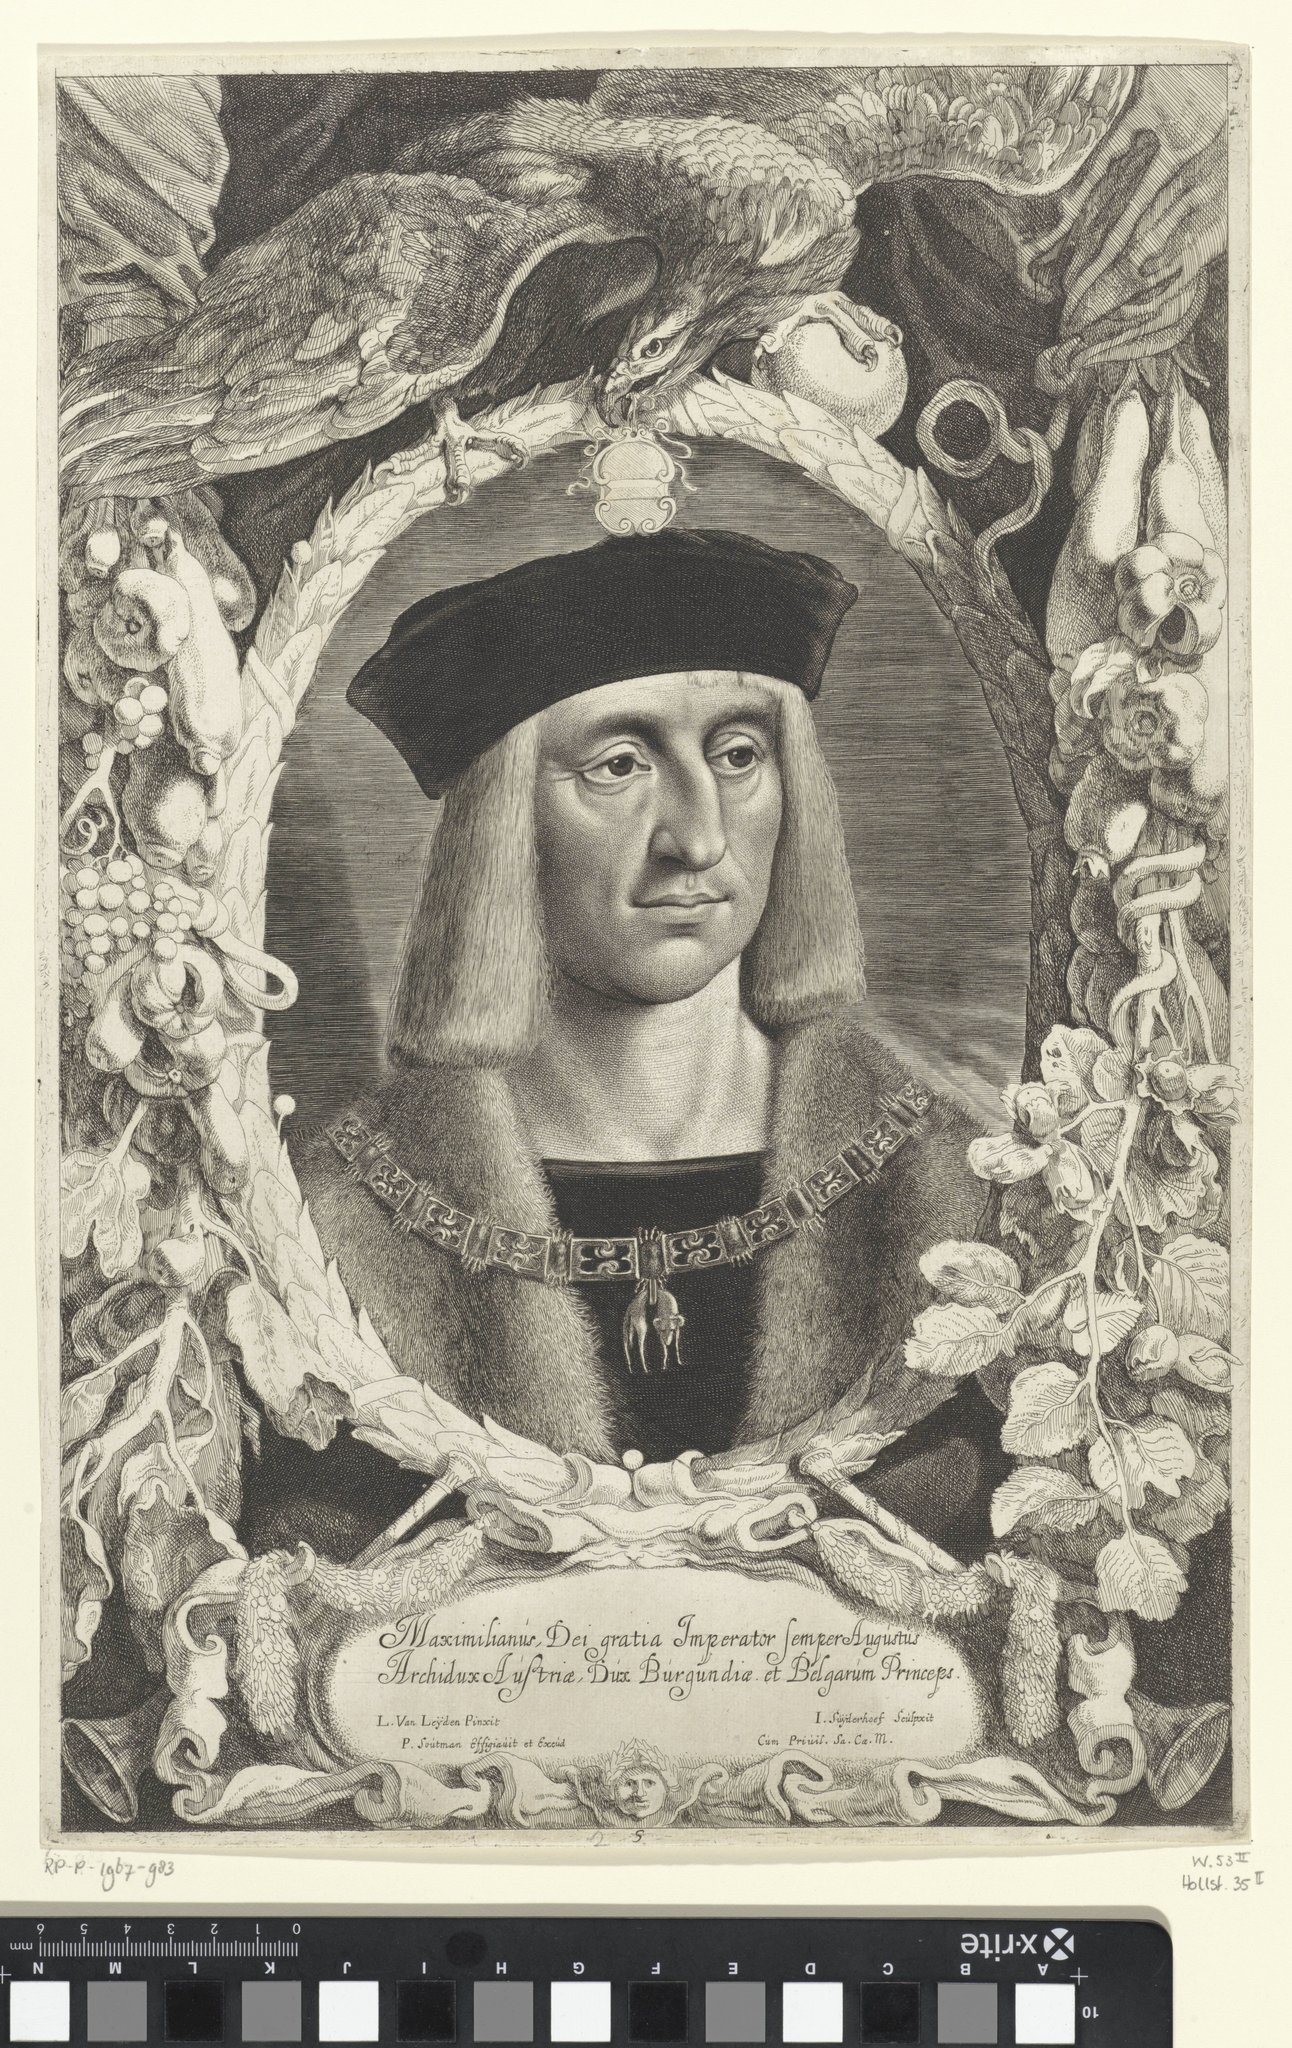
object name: print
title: Duces Burgundiae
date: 1644-1650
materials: paper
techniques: engraving, etching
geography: haarlem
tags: maximilian i (holy roman emperor), knighthood order of the golden fleece - insignia of a knighthood order, e.g.: badge, chain (with name of order), ornament ~ festoon, garland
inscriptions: collector's mark: Lugt 2228, collector's mark: Lugt 2760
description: Portret van Maximiliaan I van Habsburg, Rooms-Duits keizer, met een keten met het ordeteken van de Orde van het Gulden Vlies om zijn hals. Het portret is gevat in een ornamentele omlijsting van vruchten en bladranken. Midden boven toont een adelaar zijn wapenschild. Midden onder een cartouche met zijn naam en titel in het Latijn.